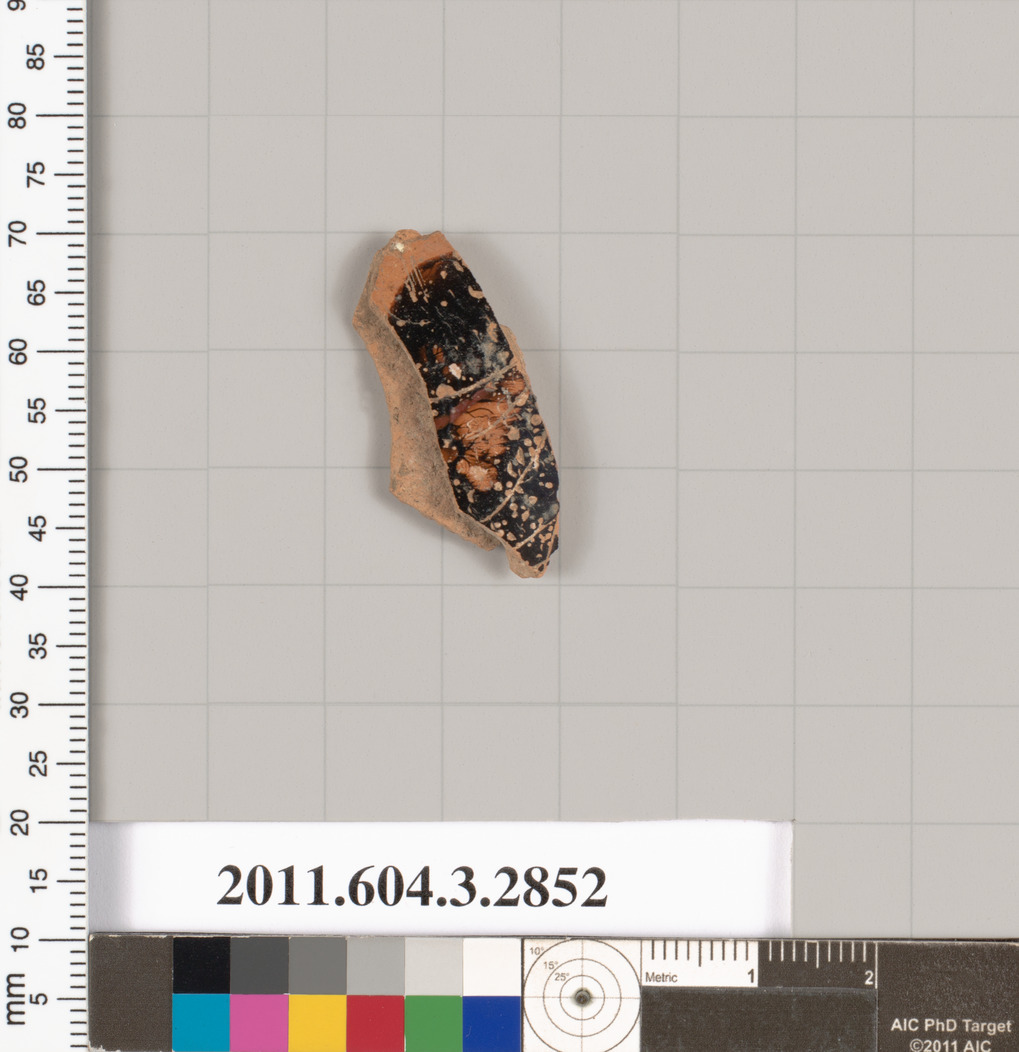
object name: undetermined closed shape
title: Terracotta fragment of a closed shape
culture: greek, attic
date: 534-468 BCE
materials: terracotta